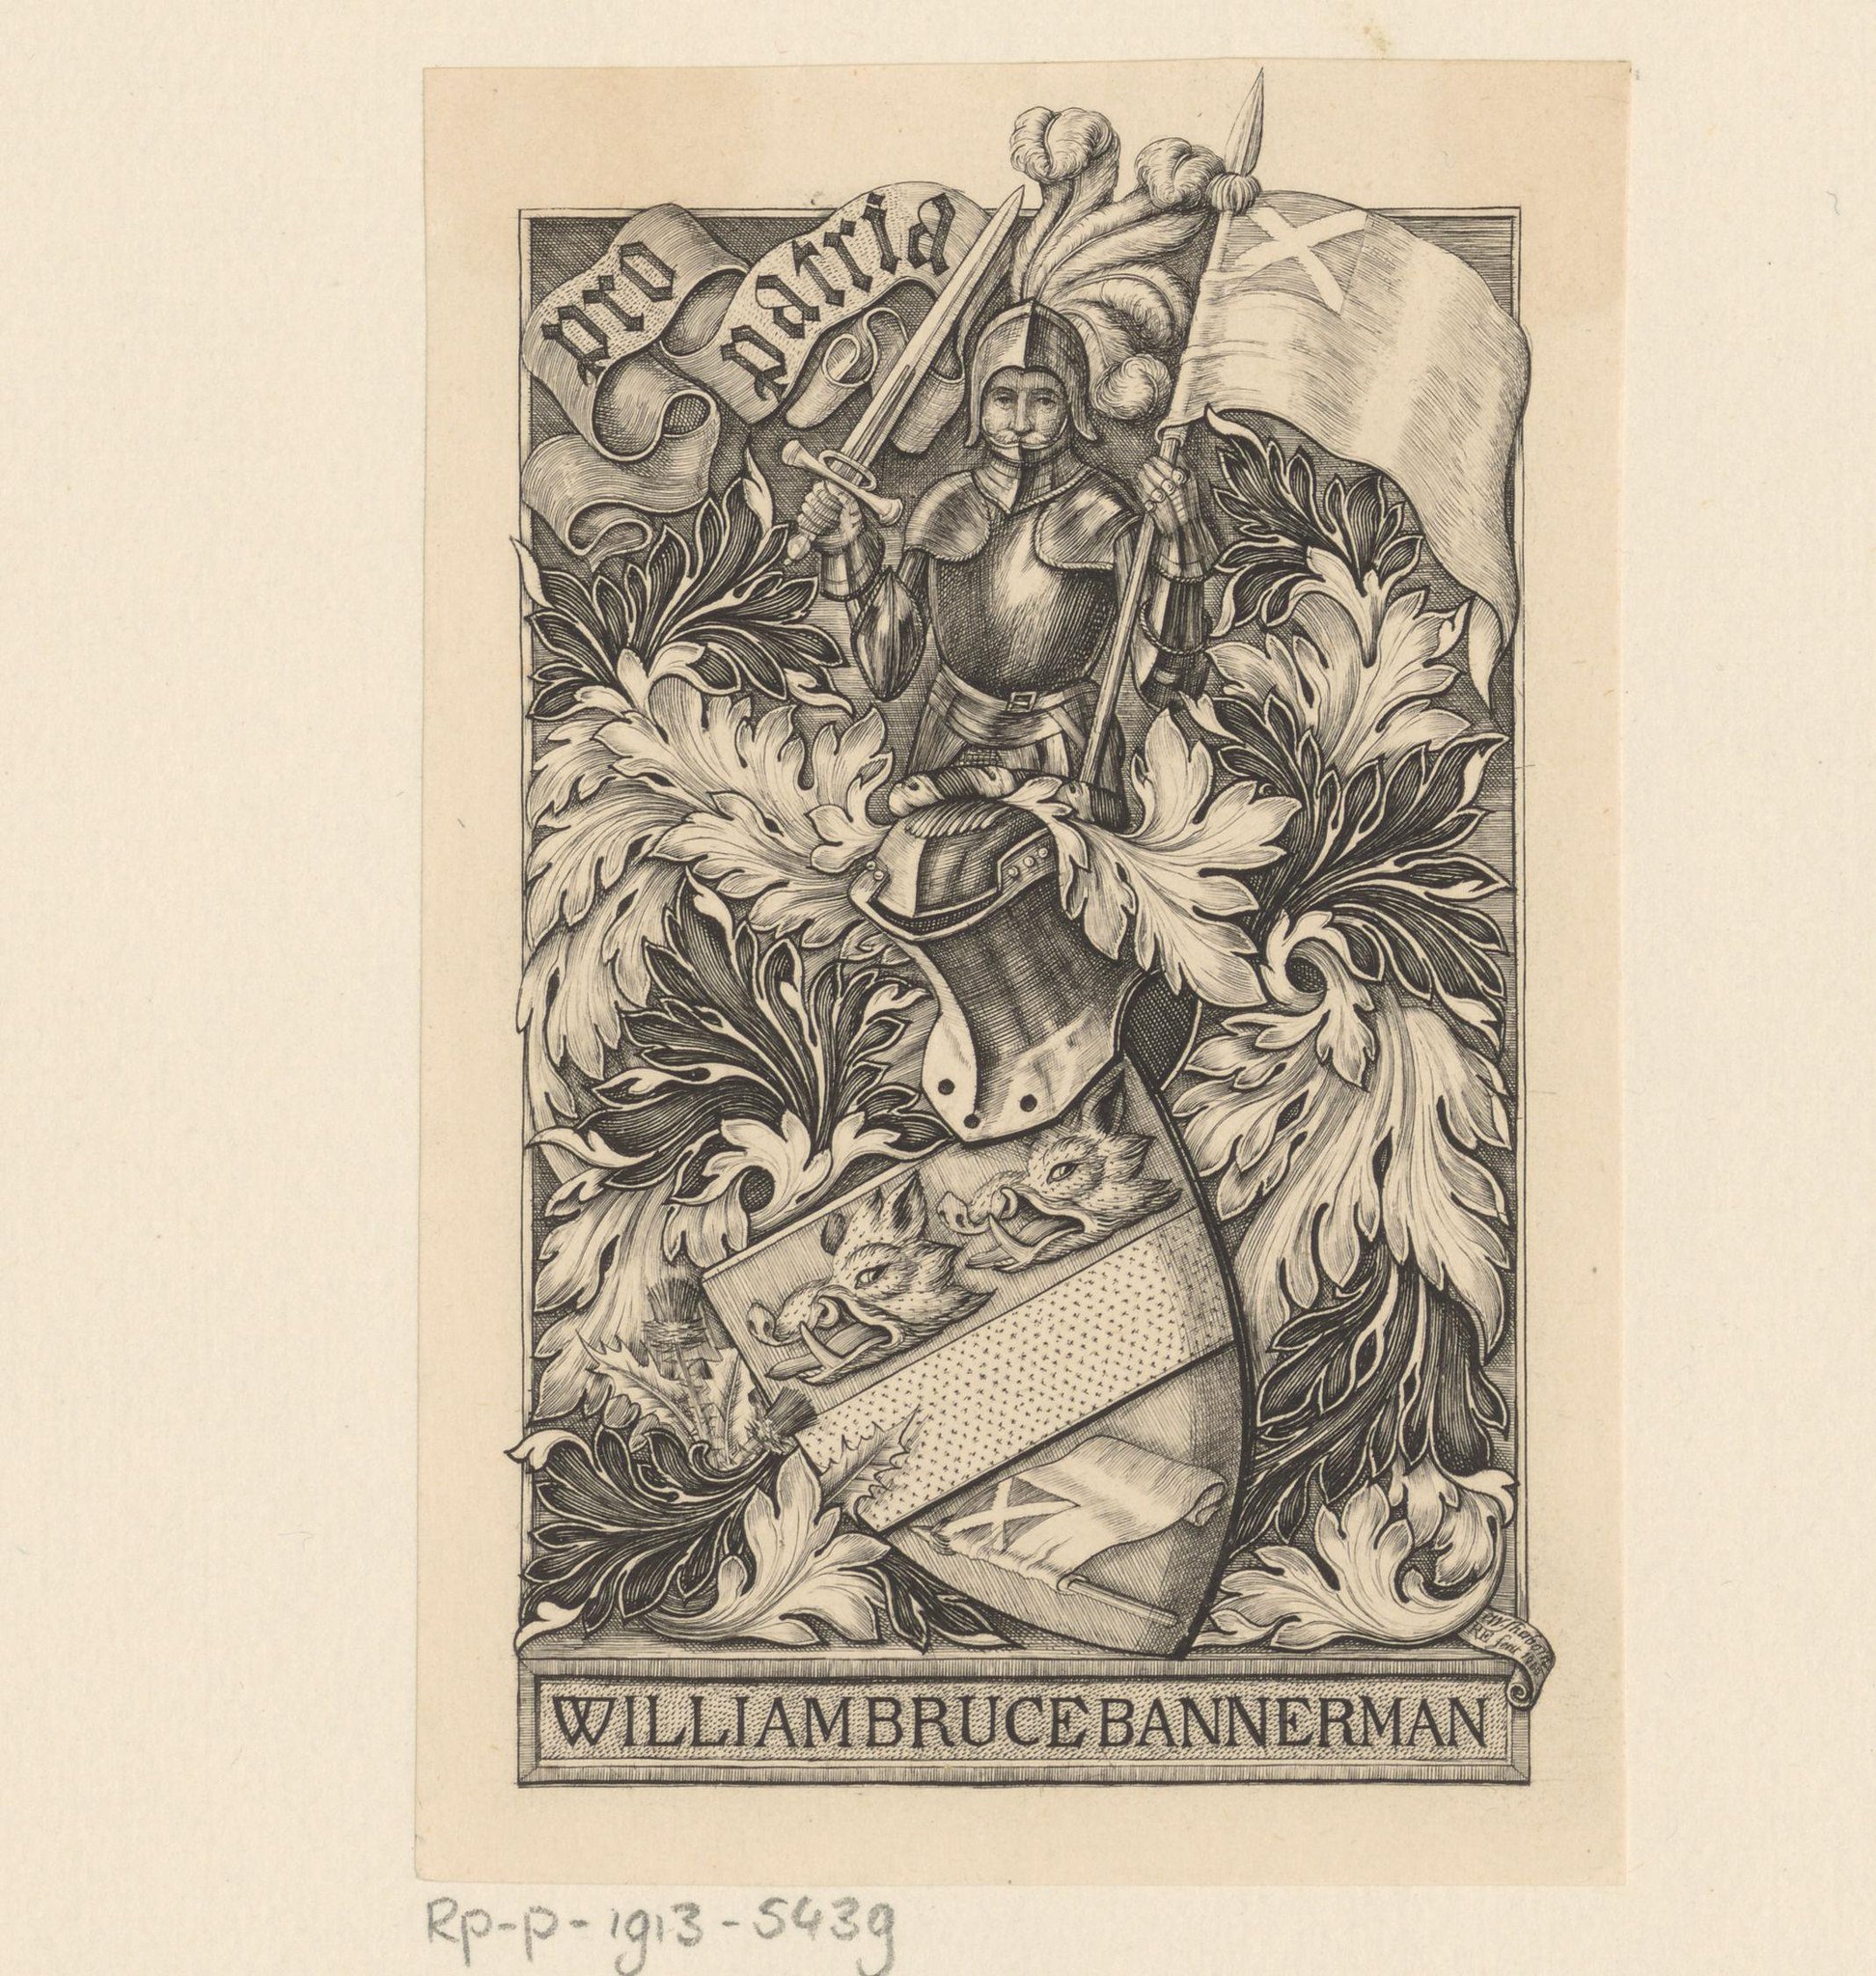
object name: bookplate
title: Pro patria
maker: charles william sherborn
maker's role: print maker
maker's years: 1831-1912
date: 1900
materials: paper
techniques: engraving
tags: knight, armorial bearing, heraldry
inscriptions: collector's mark: Lugt 2760, collector's mark: Lugt 2233